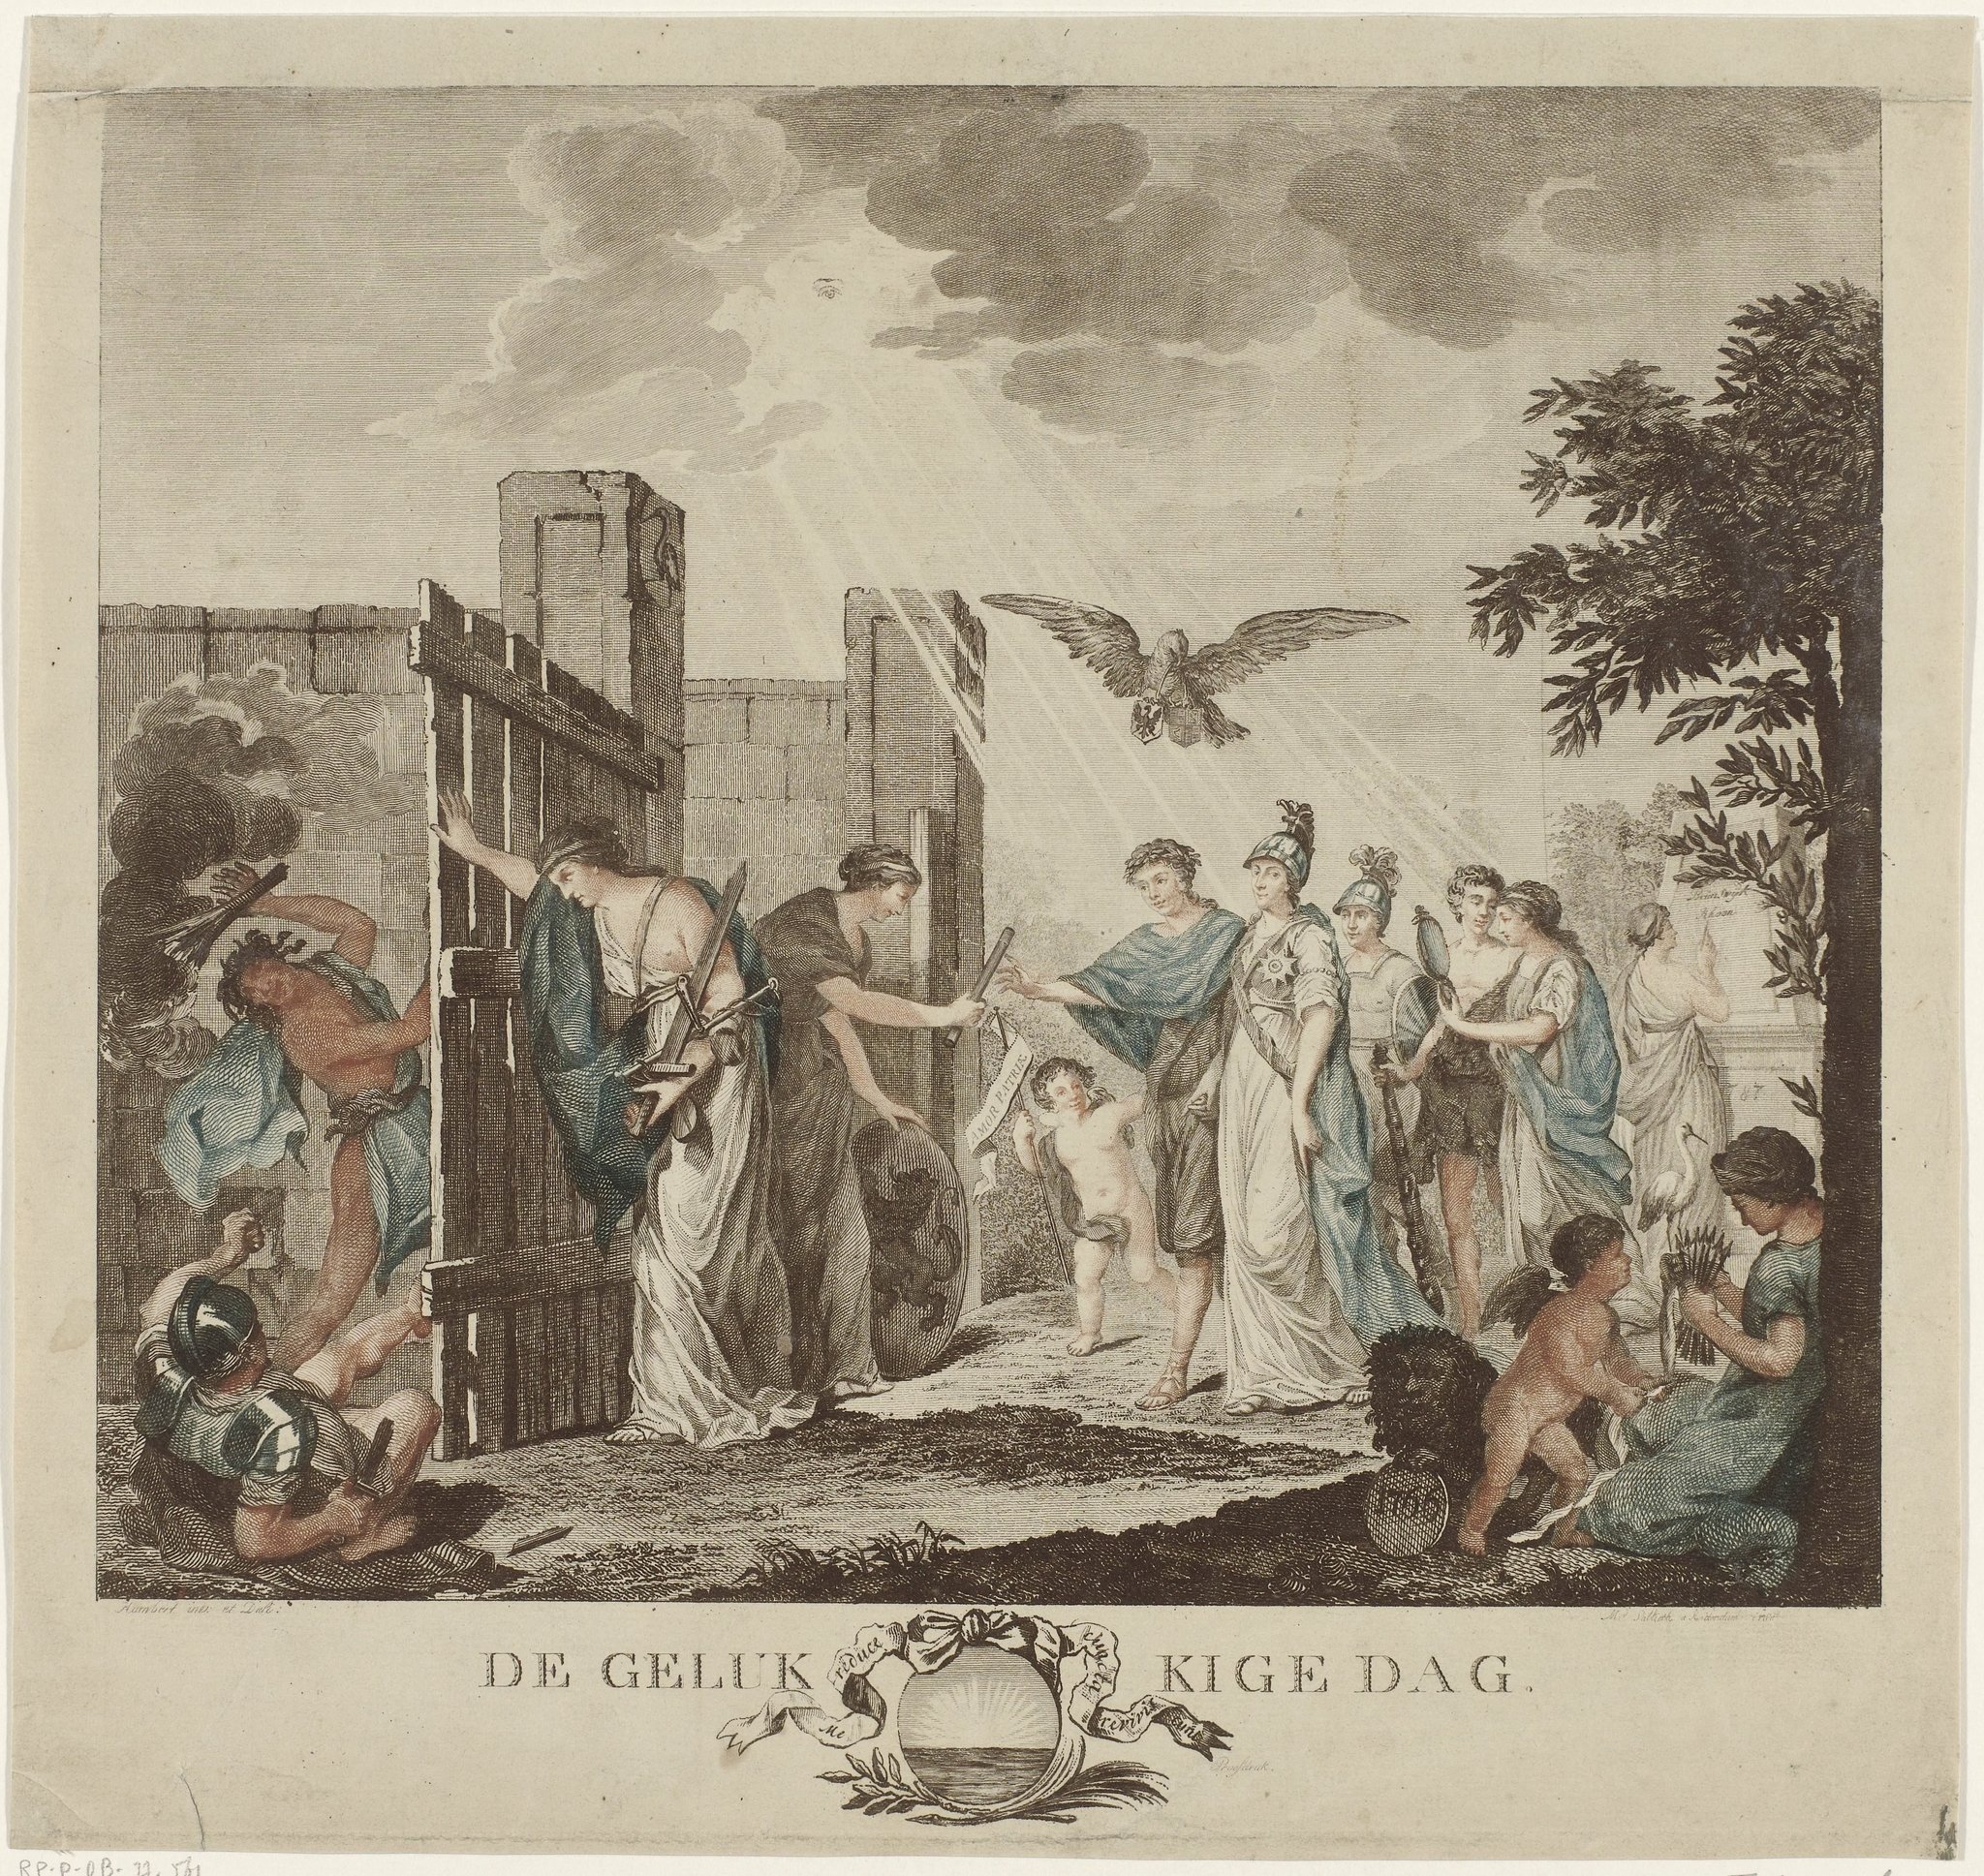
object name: print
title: Allegorie op het herstel van de stadhouder Willem V, 1787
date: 1788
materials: paper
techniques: lithography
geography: rotterdam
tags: william v (prince of orange), karel willem ferdinand hertog van brunswijk-wolfenbüttel, 'amor della patria' (ripa), the all-seeing eye, triangle with eye ~ symbol of god the father, the hague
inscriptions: title: ‘DE GELUKKIGE DAG’, collector's mark: Lugt 2228, signature and date: ‘M. Sallieth sc. Rotterdam 1788’, signature: ‘Humbert inv. et del.’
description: Allegorische voorstelling op het herstel van de stadhouder Willem V en zijn inhaling in Den Haag op 20 september 1787. Gerechtigheid opent de poort voor een jonge vorst (prins Willem V), zodat de weg naar Den Haag voor hem vrij is. Wangunst en Gewapende Woede proberen tevergeefs de deur tegen te houden. De Provincie Holland geeft hem de commandostaf terug. Rechtsvoor de Hollandse Leeuw met het jaartal 1766 (toen de prins stadhouder werd). Op de achtergrond graveert de Dankbaarheid de namen Brunswijk en Rhoon op een erezuil. Vanuit de hemel kijkt het Alziende Oog neer op de gebeurtenissen. Bij de prent behoort een tekstblad.